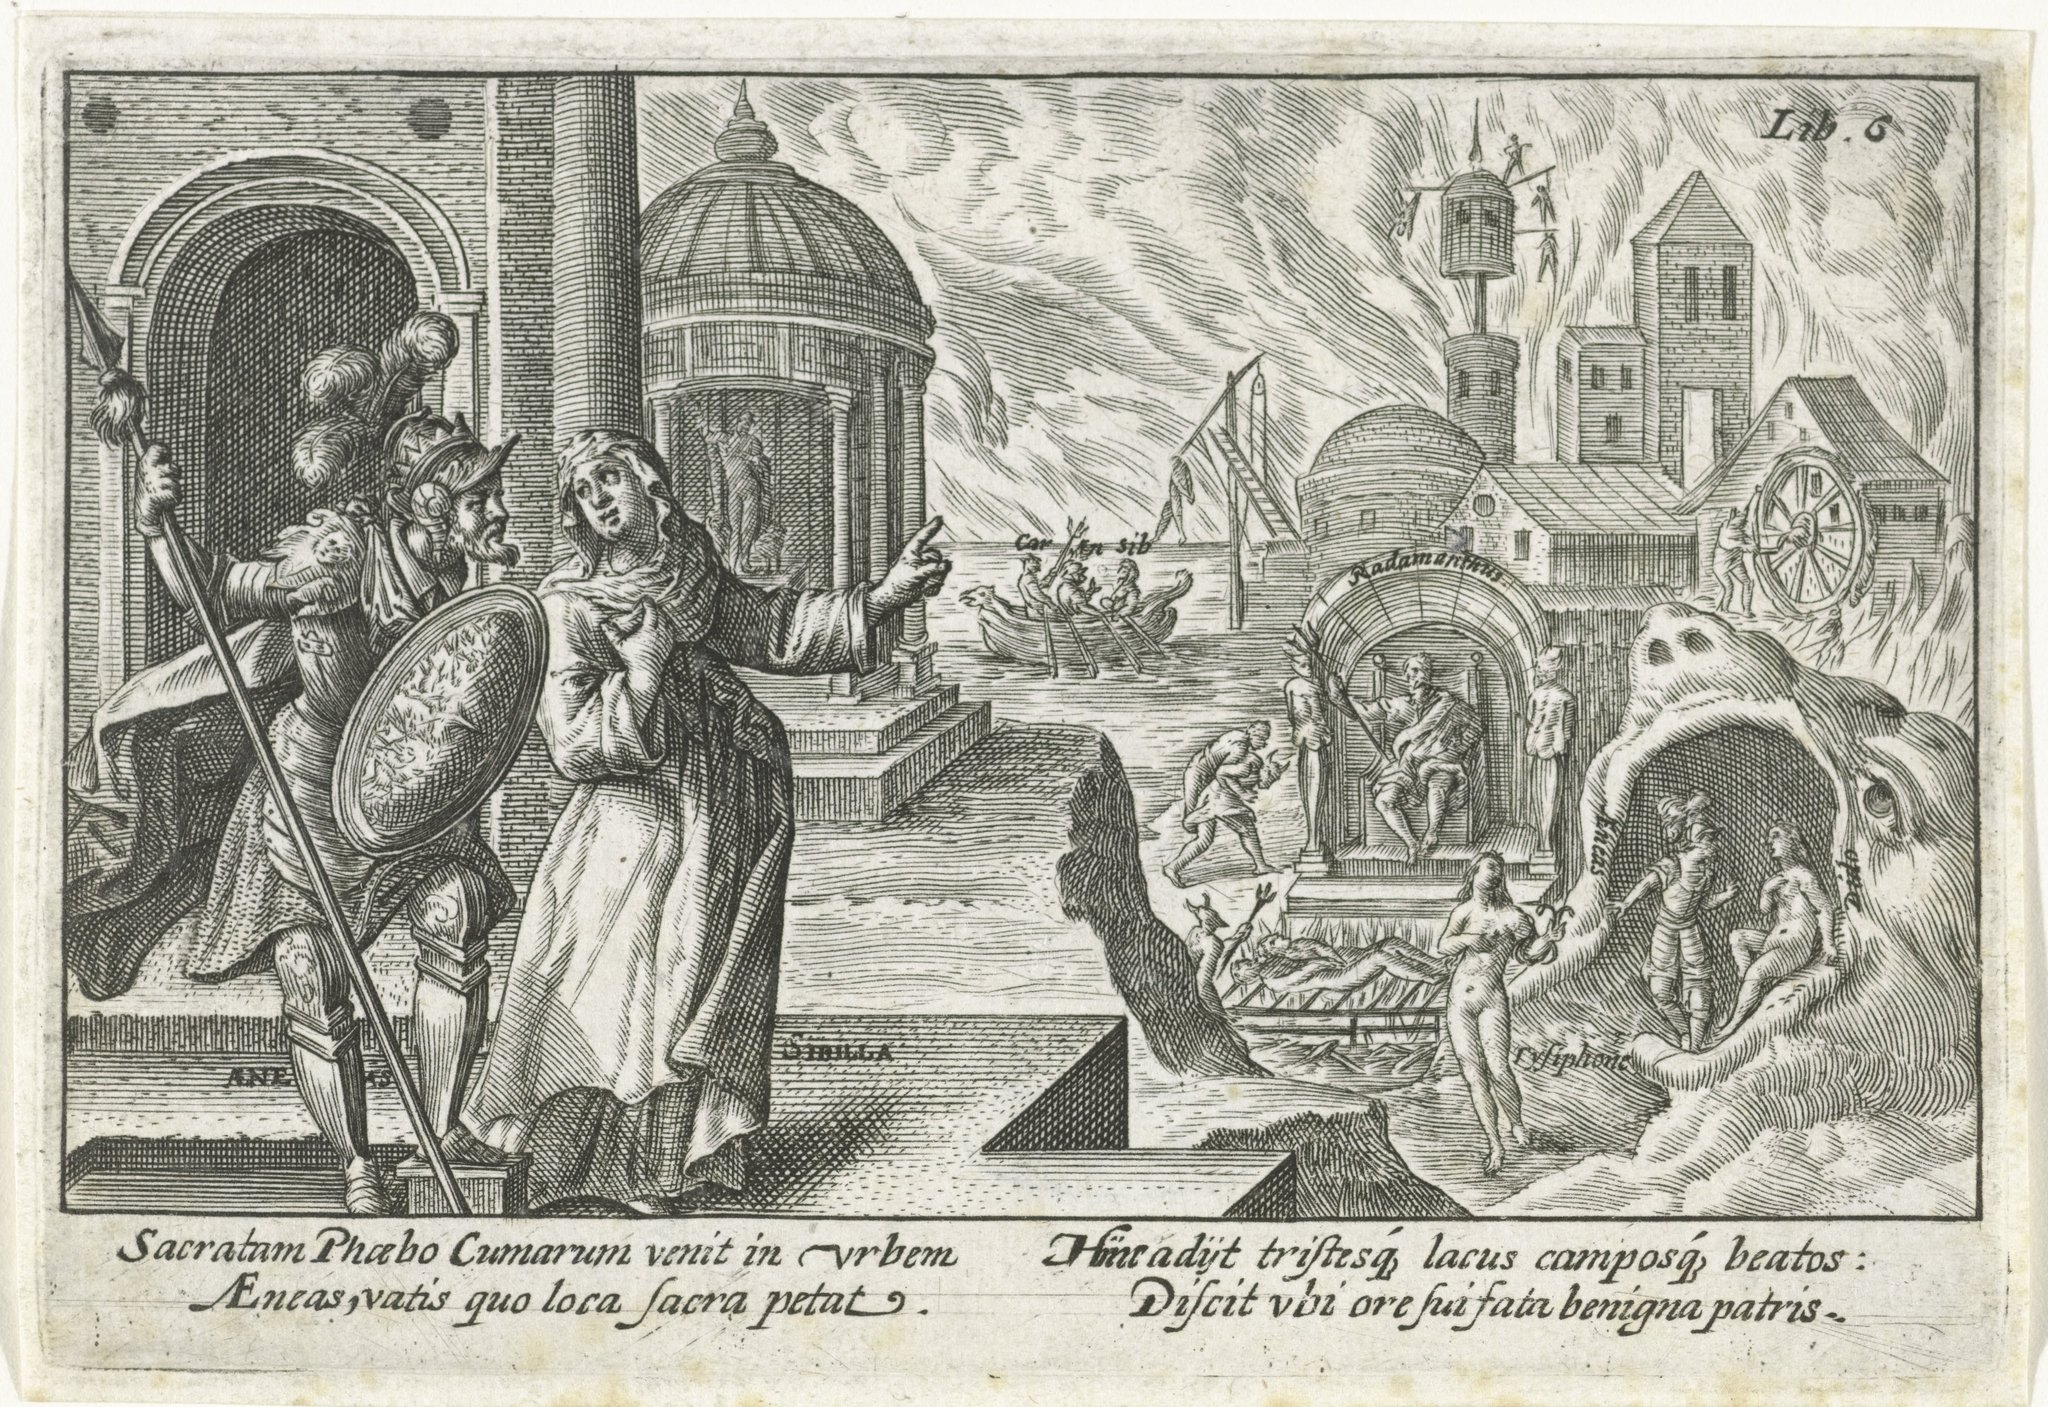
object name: print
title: Speculum Aeneidis Virgilianae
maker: crispijn van de passe (i)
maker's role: draughtsman, print maker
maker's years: 1564-1637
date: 1612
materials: paper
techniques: engraving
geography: utrecht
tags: aeneas, guided by the sibyl, enters the underworld through the cave of avernus, aeneas and the sibyl meet various groups of the dead, among them is dido, who turns aside, aeneas and the sibyl pass by tartarus, charon conveys aeneas and the sibyl in his boat; they alight at the gates of pluto's kingdom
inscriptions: collector's mark: Lugt 2228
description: Aeneas bezoekt de Sibille van Cumea, samen dalen zij af in de onderwereld. Op de achtergrond Aeneas, beschermd door een maretak, en de Sibille, in Charons boot. Onder de doden treft Aeneas Dido aan. In de marge een vierregelig onderschrift, in twee kolommen, in het Latijn.